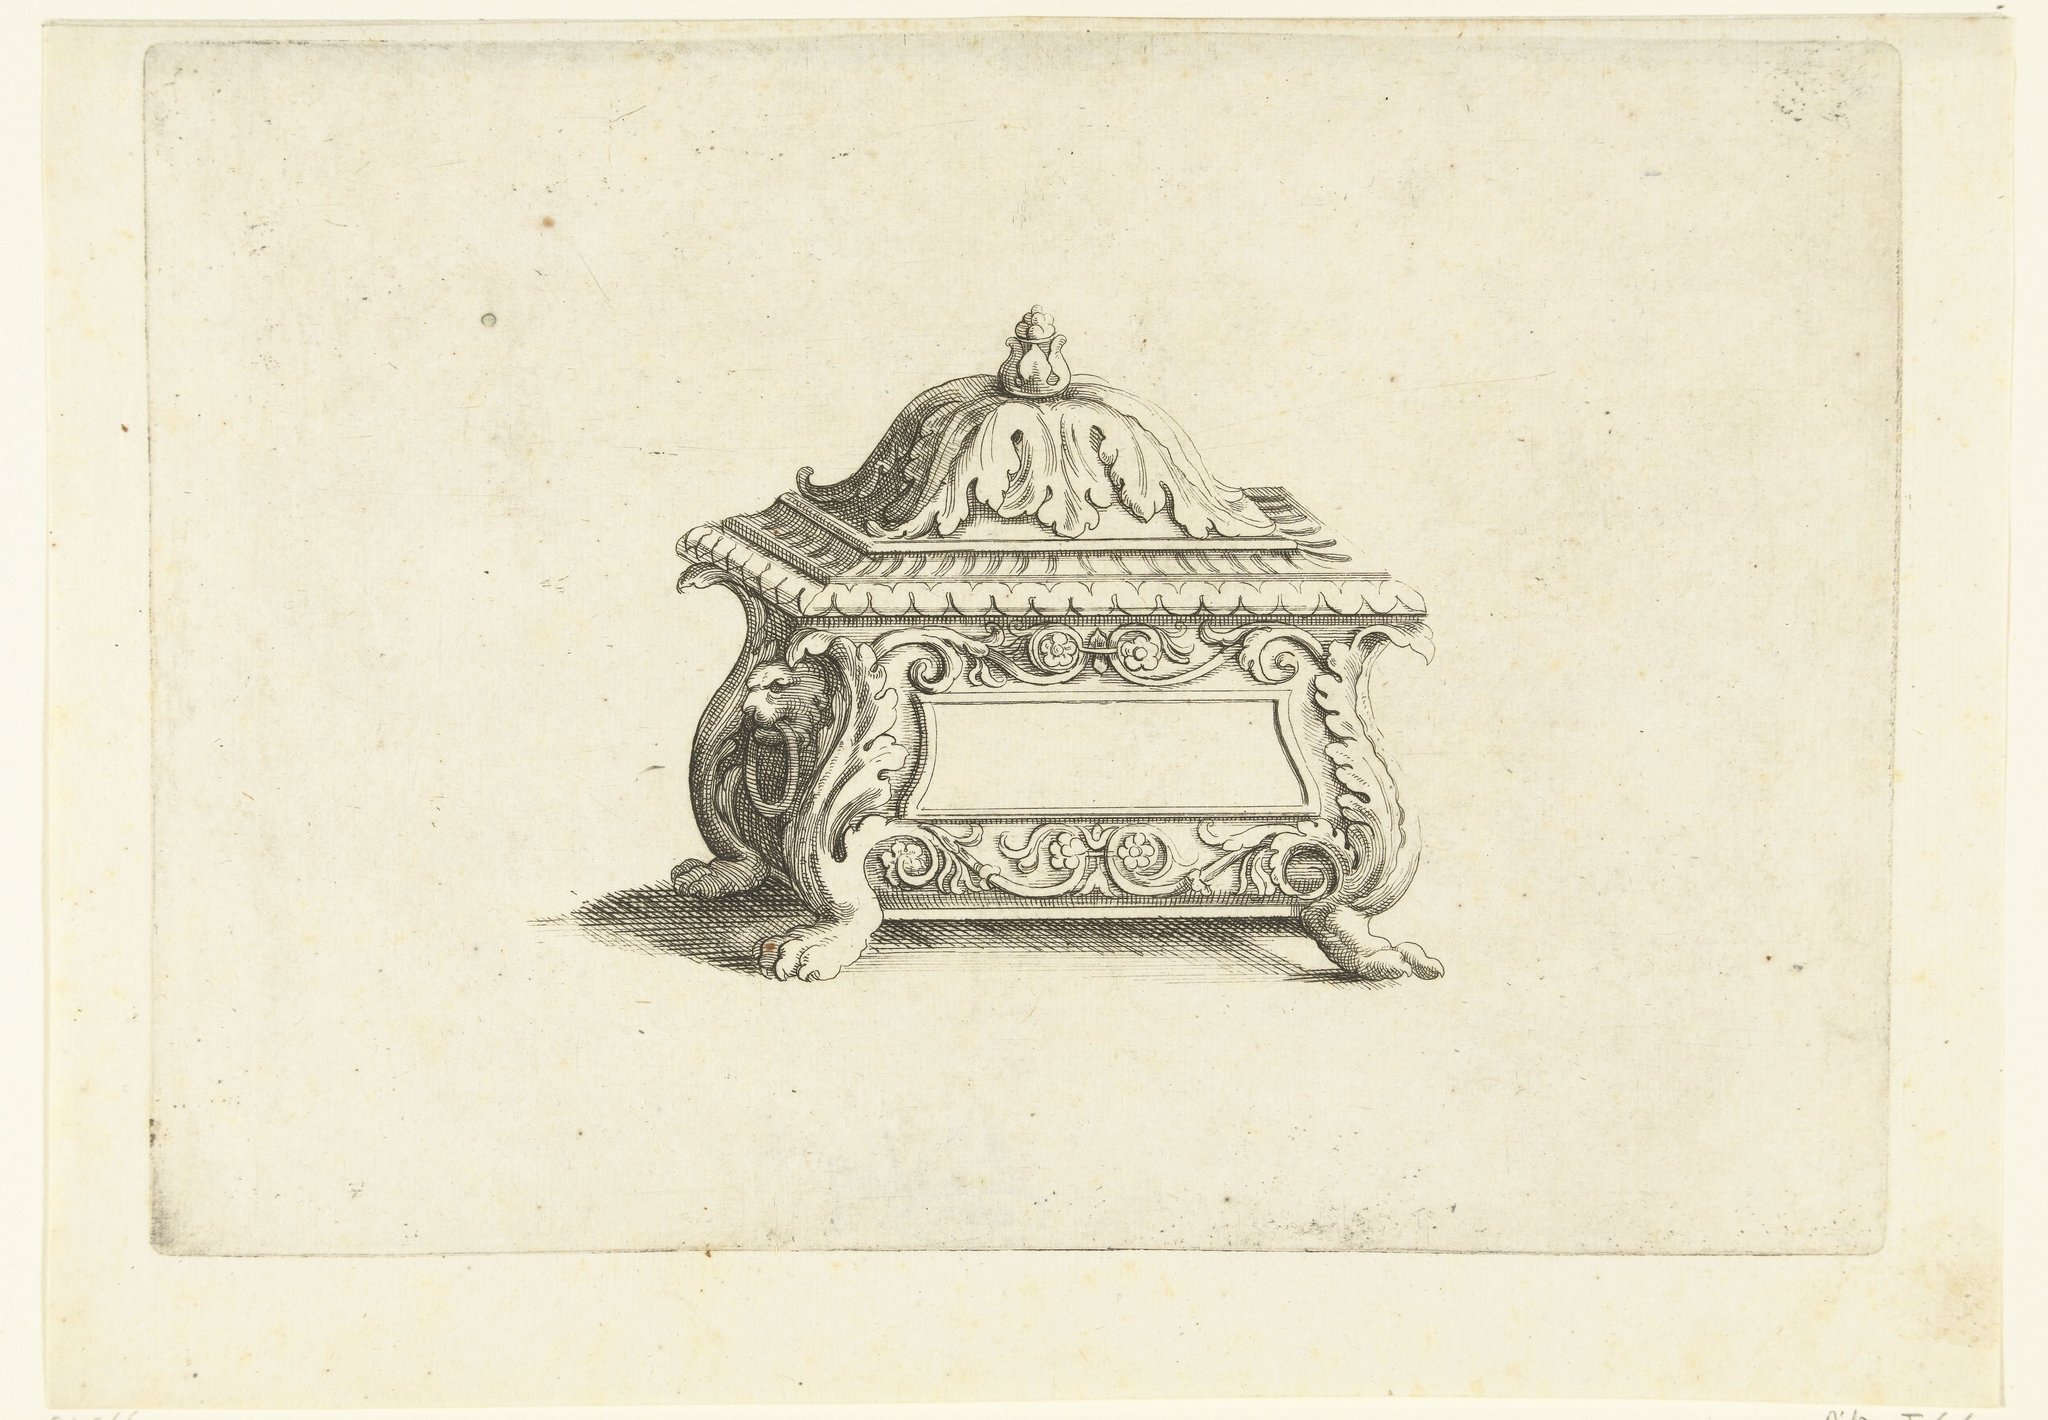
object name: print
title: Kistje met deksel en ringen aan de zijkant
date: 1614-1654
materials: paper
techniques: etching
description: De voorzijde van het kistje is gedecoreerd met een lege cartouche en bladranken. Uit serie van 14 bladen met schalen, kommen en kistjes.